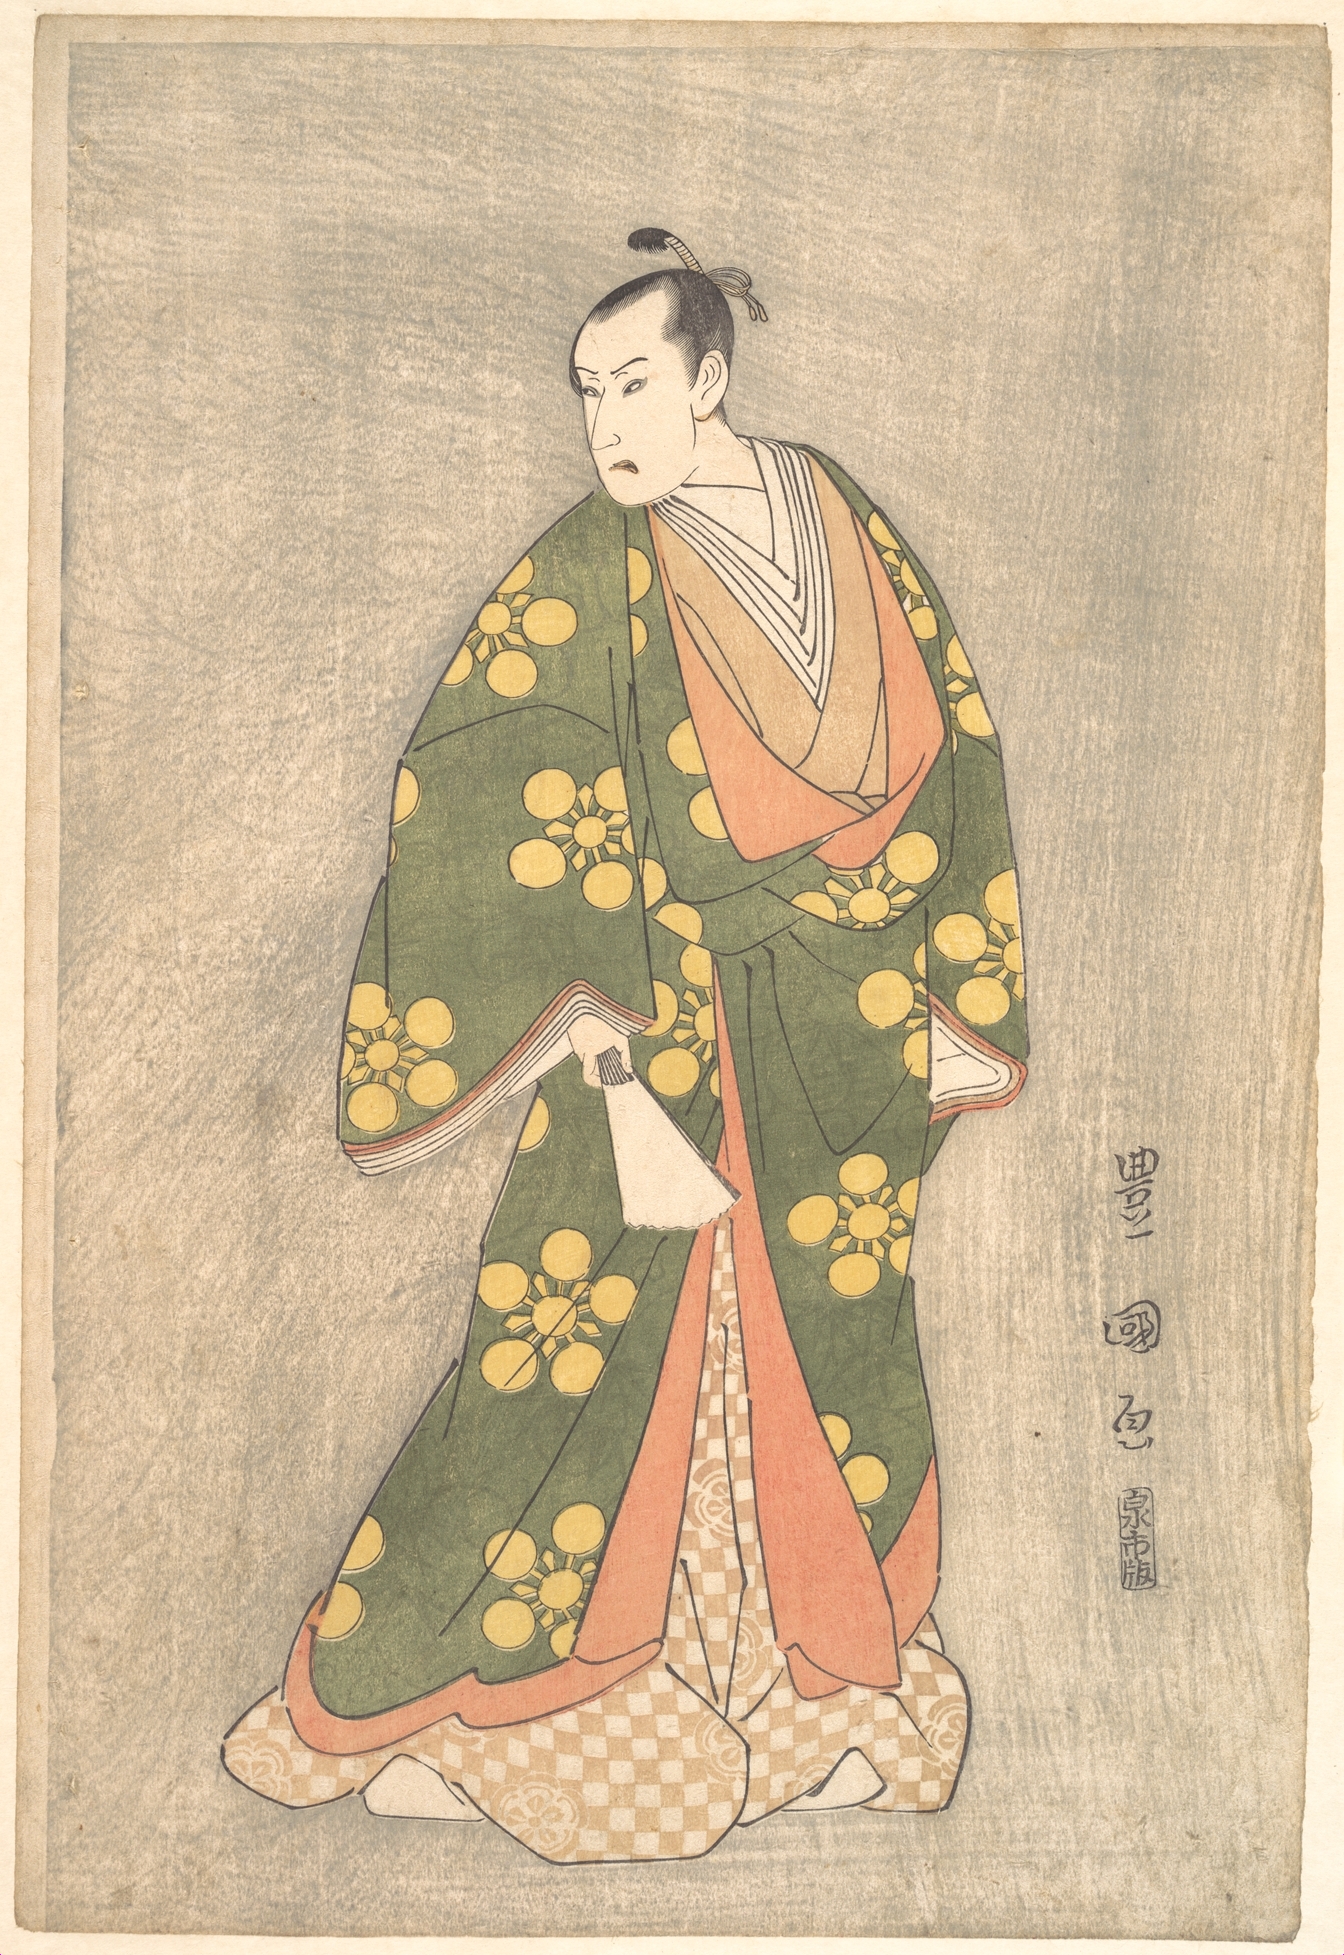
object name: print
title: Bandō Hikosaburō III in the Role of Sugawara no Michizane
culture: japanese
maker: utagawa toyokuni i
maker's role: artist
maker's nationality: japanese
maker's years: 1769-1825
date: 1796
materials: ink, paper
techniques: woodblock print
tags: men,actors